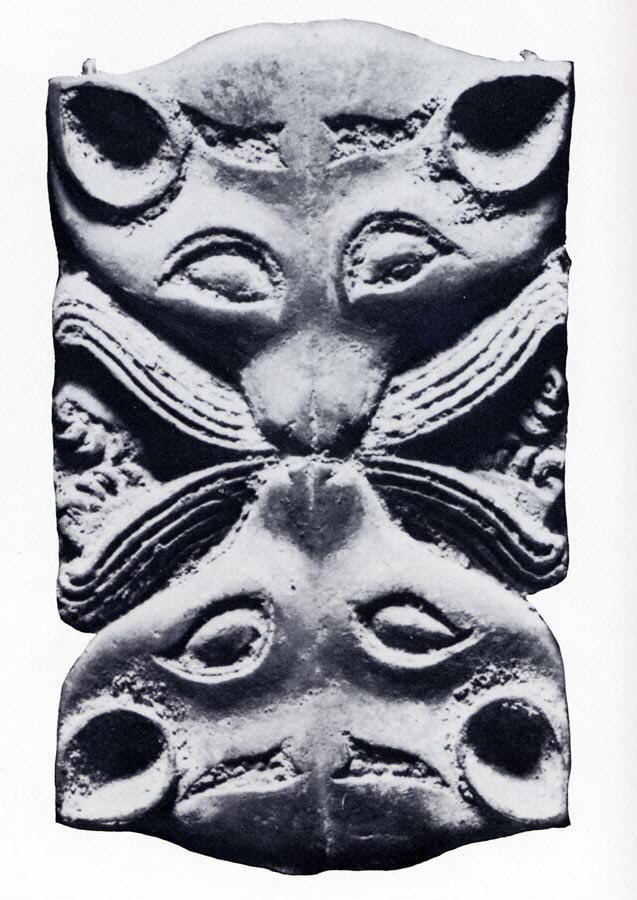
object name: plaque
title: Plaque with Confronted Animal Heads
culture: north chinese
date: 300-1 BCE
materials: bronze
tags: animals